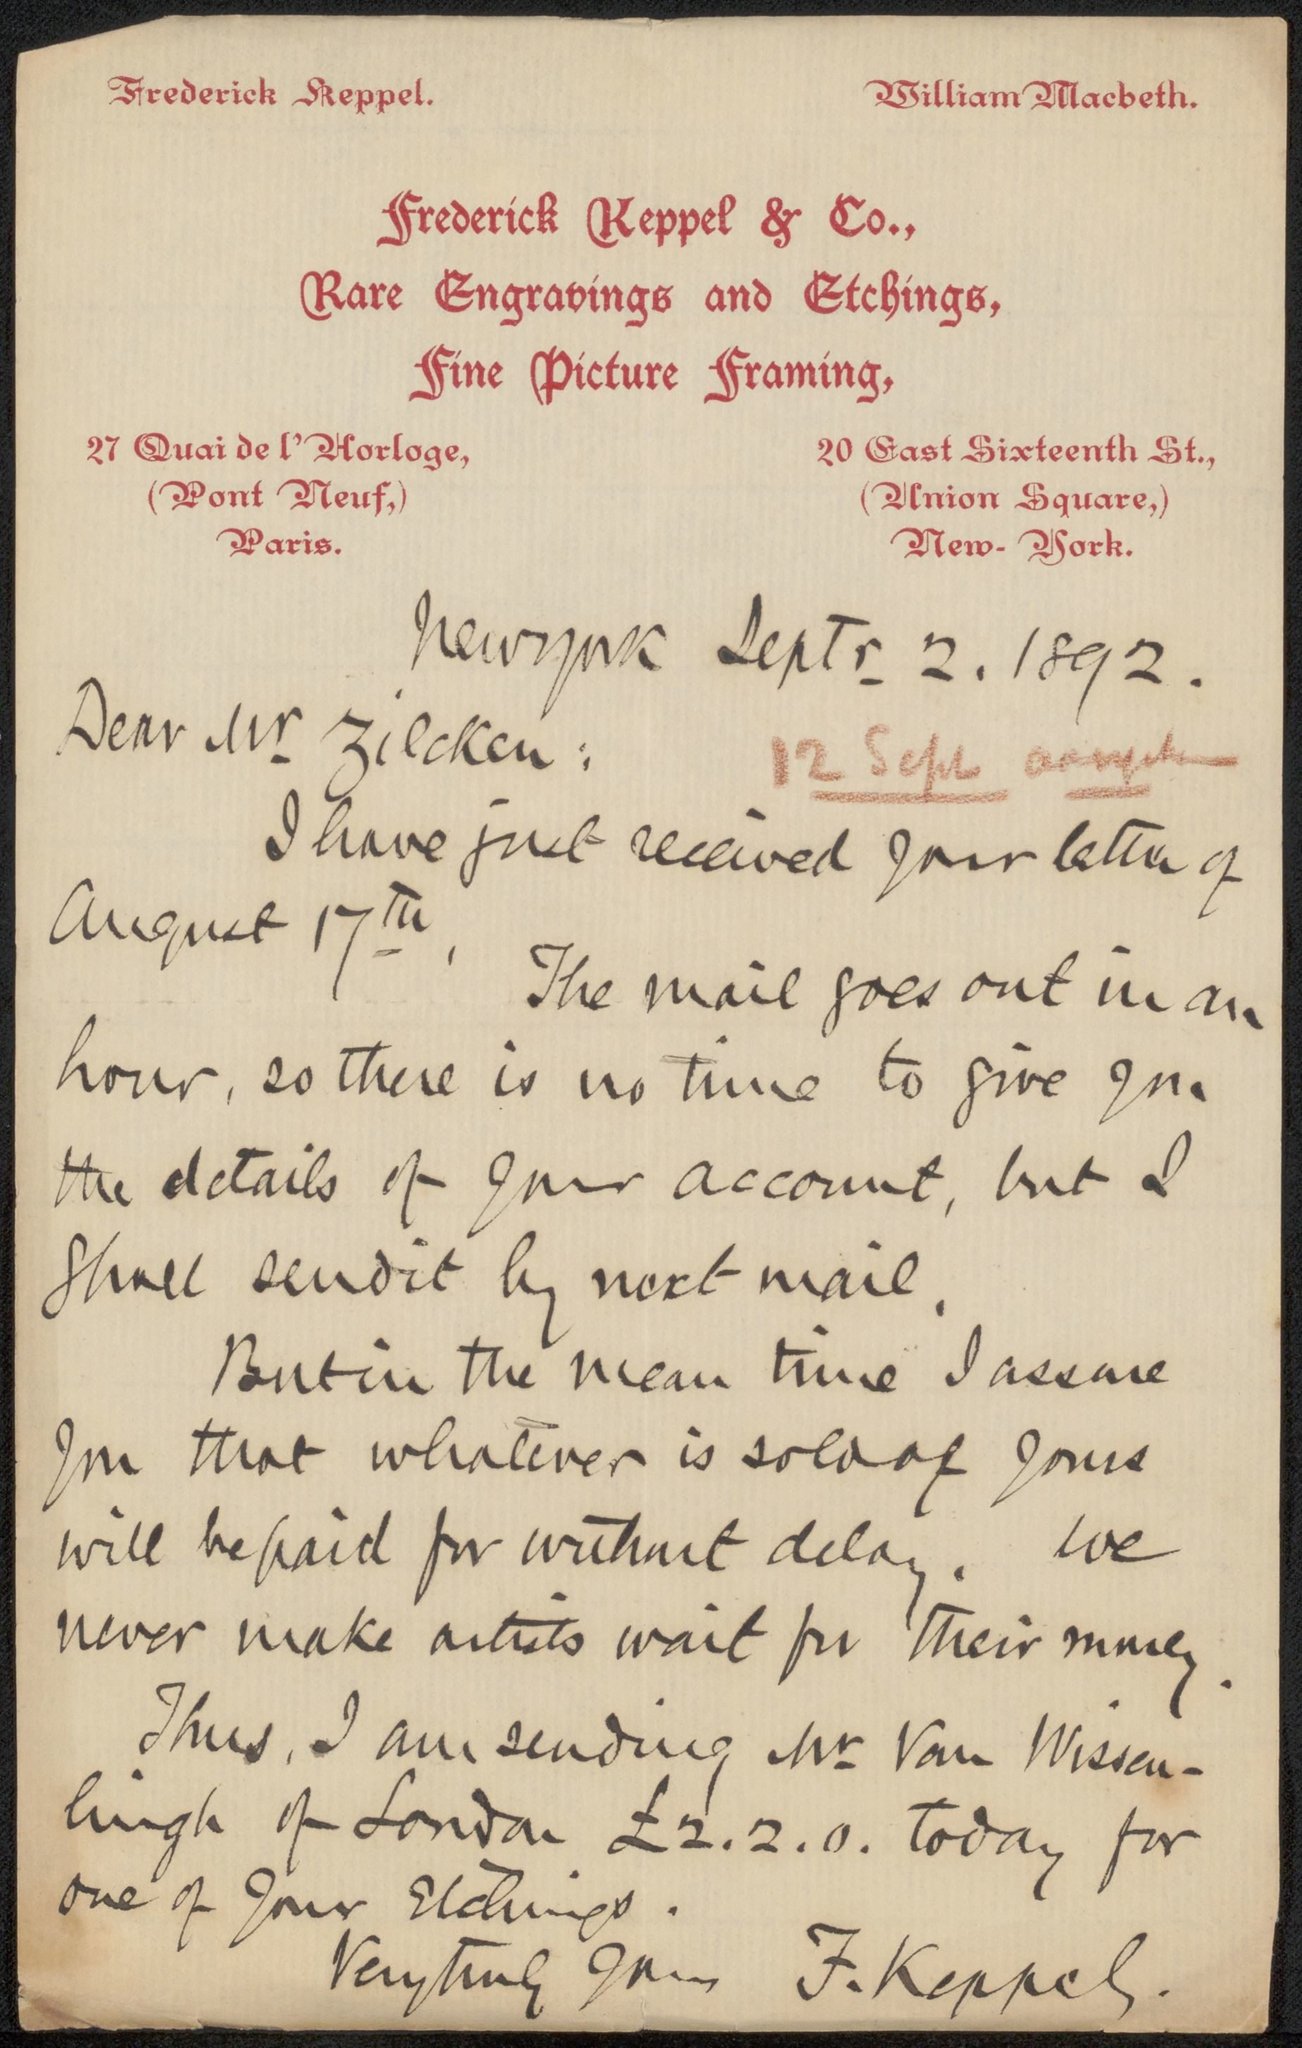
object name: letter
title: Brief aan Philip Zilcken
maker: frederick keppel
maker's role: criticus, kunsthandelaar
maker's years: 1845-1912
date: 1892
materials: ink, paper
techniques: pen, printing, writing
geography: new york city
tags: the hague, painter, draughtsman, philip zilcken, art trade, art shop, the graphic arts, money, london